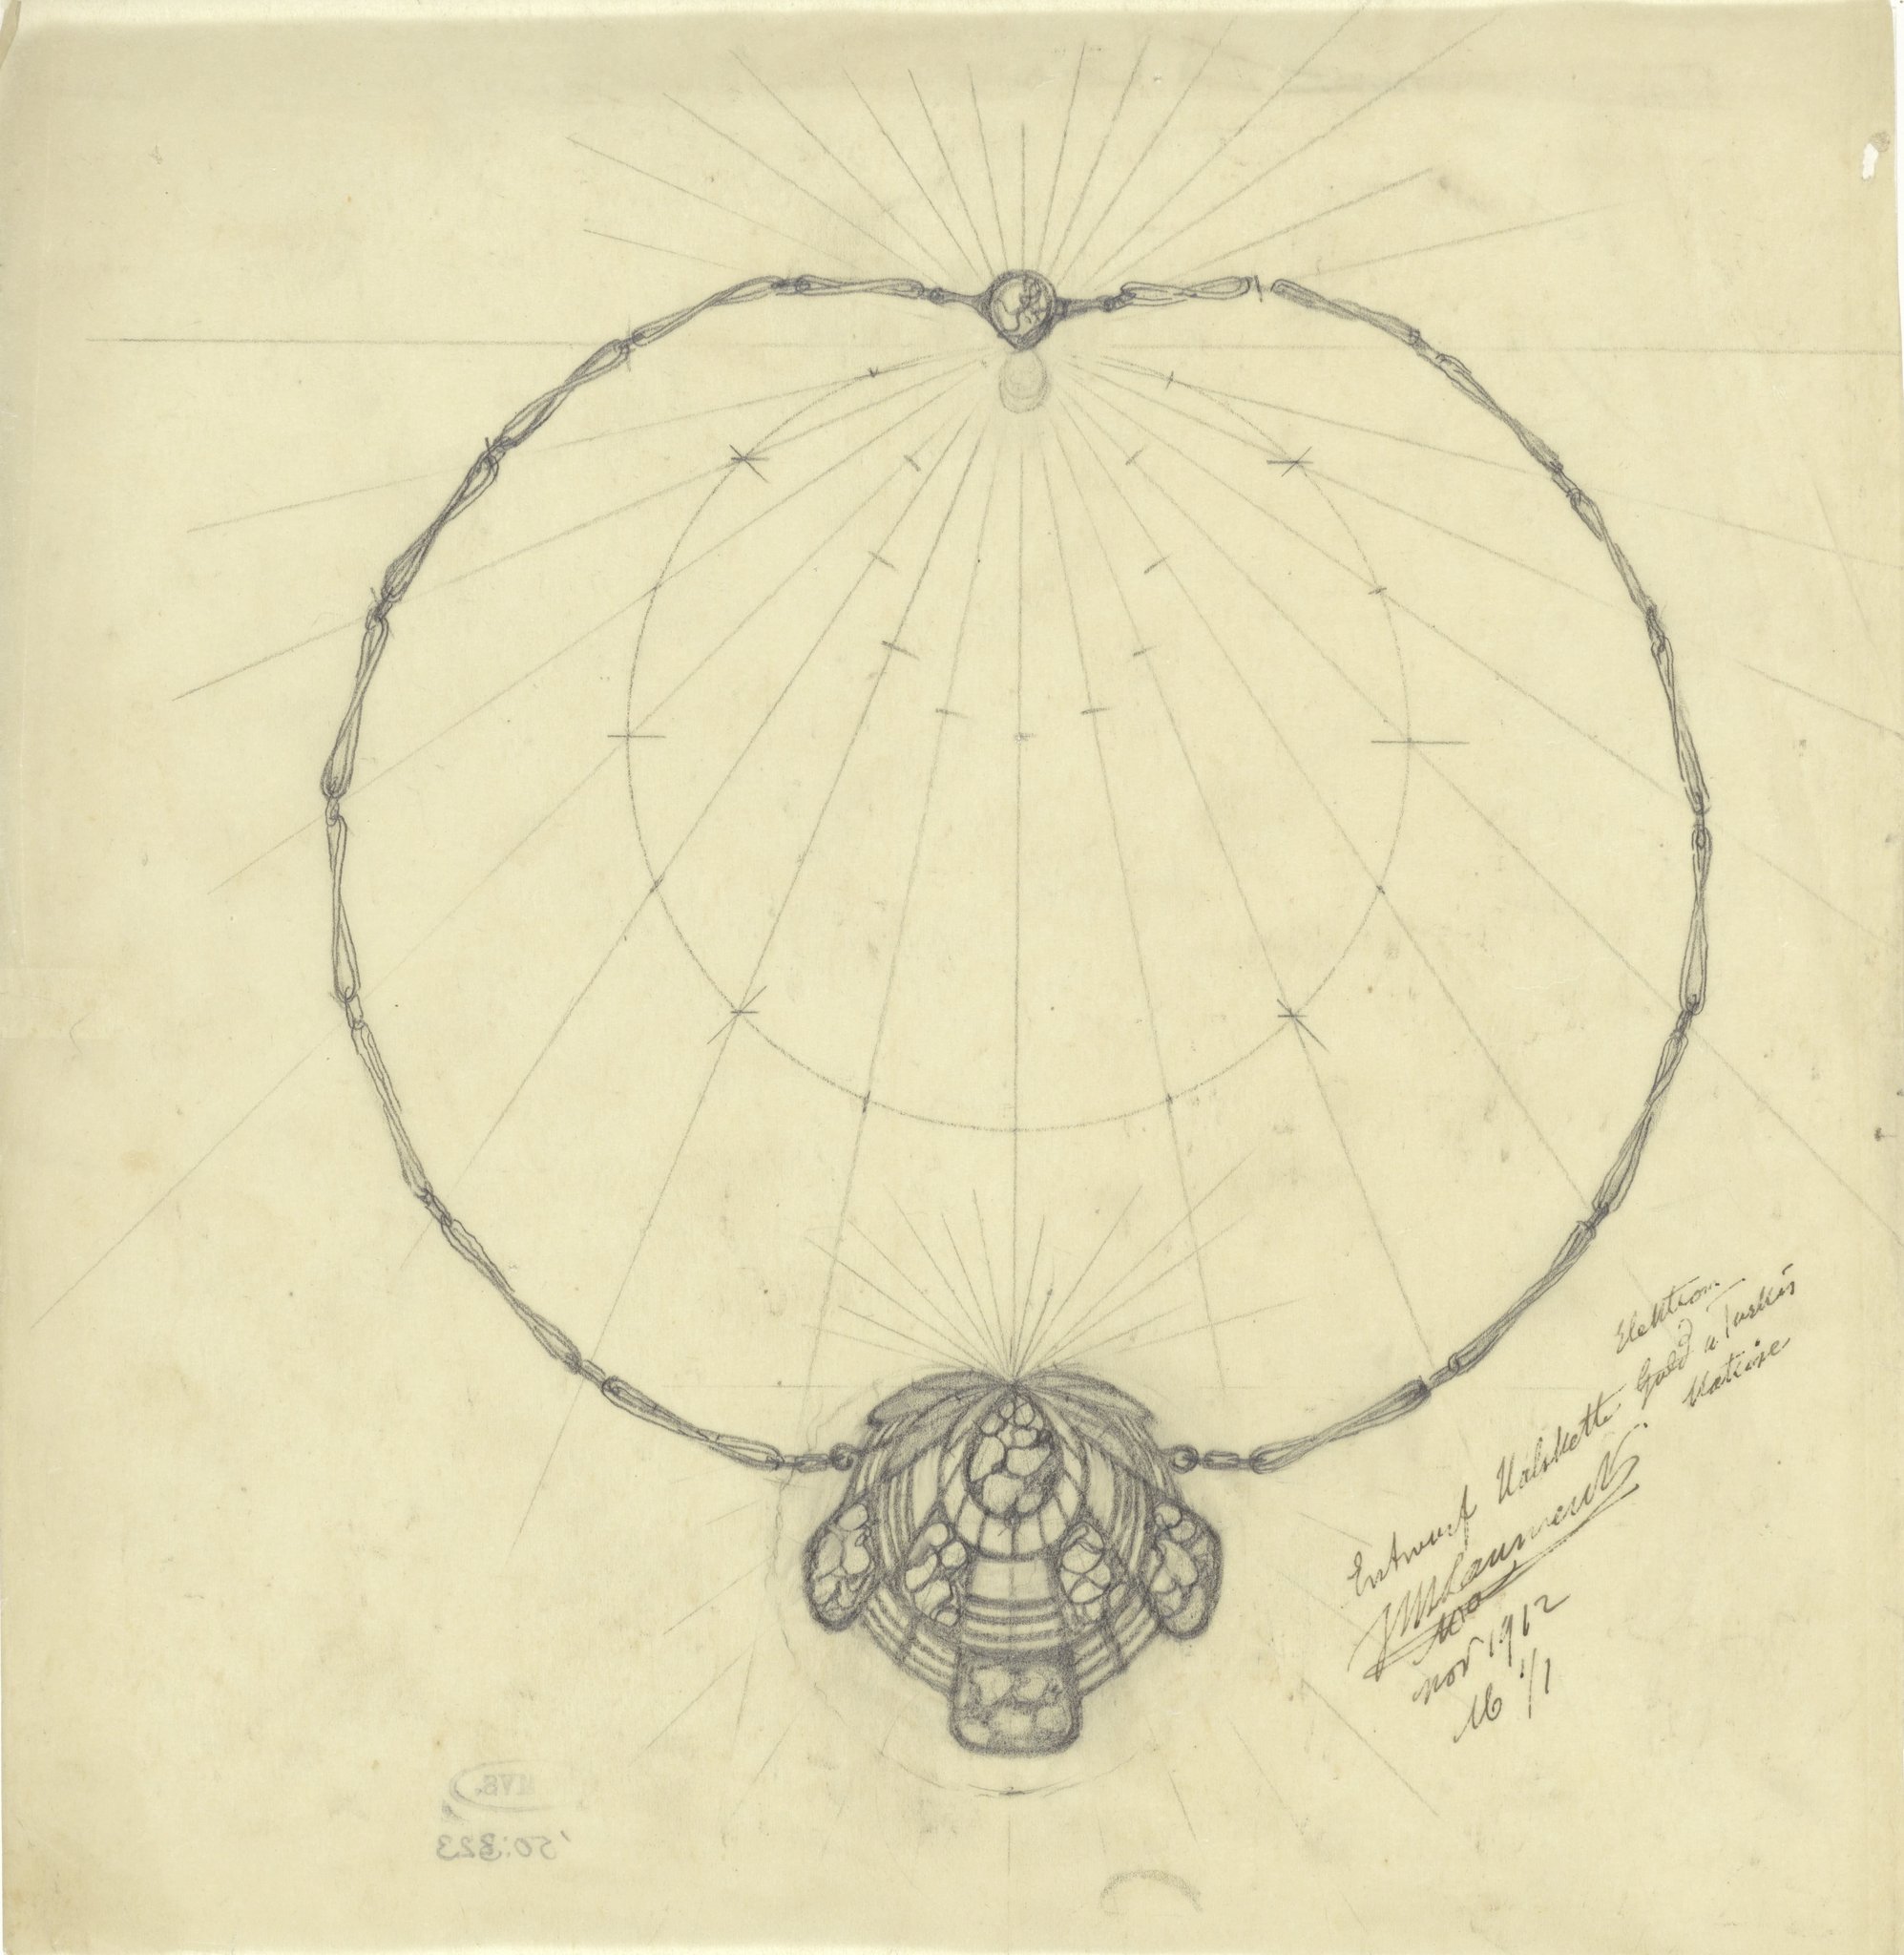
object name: design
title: Design for a Necklace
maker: mathieu lauweriks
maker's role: designer, draughtsman, print maker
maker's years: 1864-1932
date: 1911-1912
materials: pencil, paper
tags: necklace (+ women's clothes)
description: This necklace with a pendant is constructed within the pattern of a halo. Extending from one central point, the clasp, are lines that define both the proportion and length of the links. The design of the pendant follows the same principle. The drawing indicates that the necklace was to be made of turquoise and electrum, a natural alloy of gold, silver and copper with a greenishyellow hue.